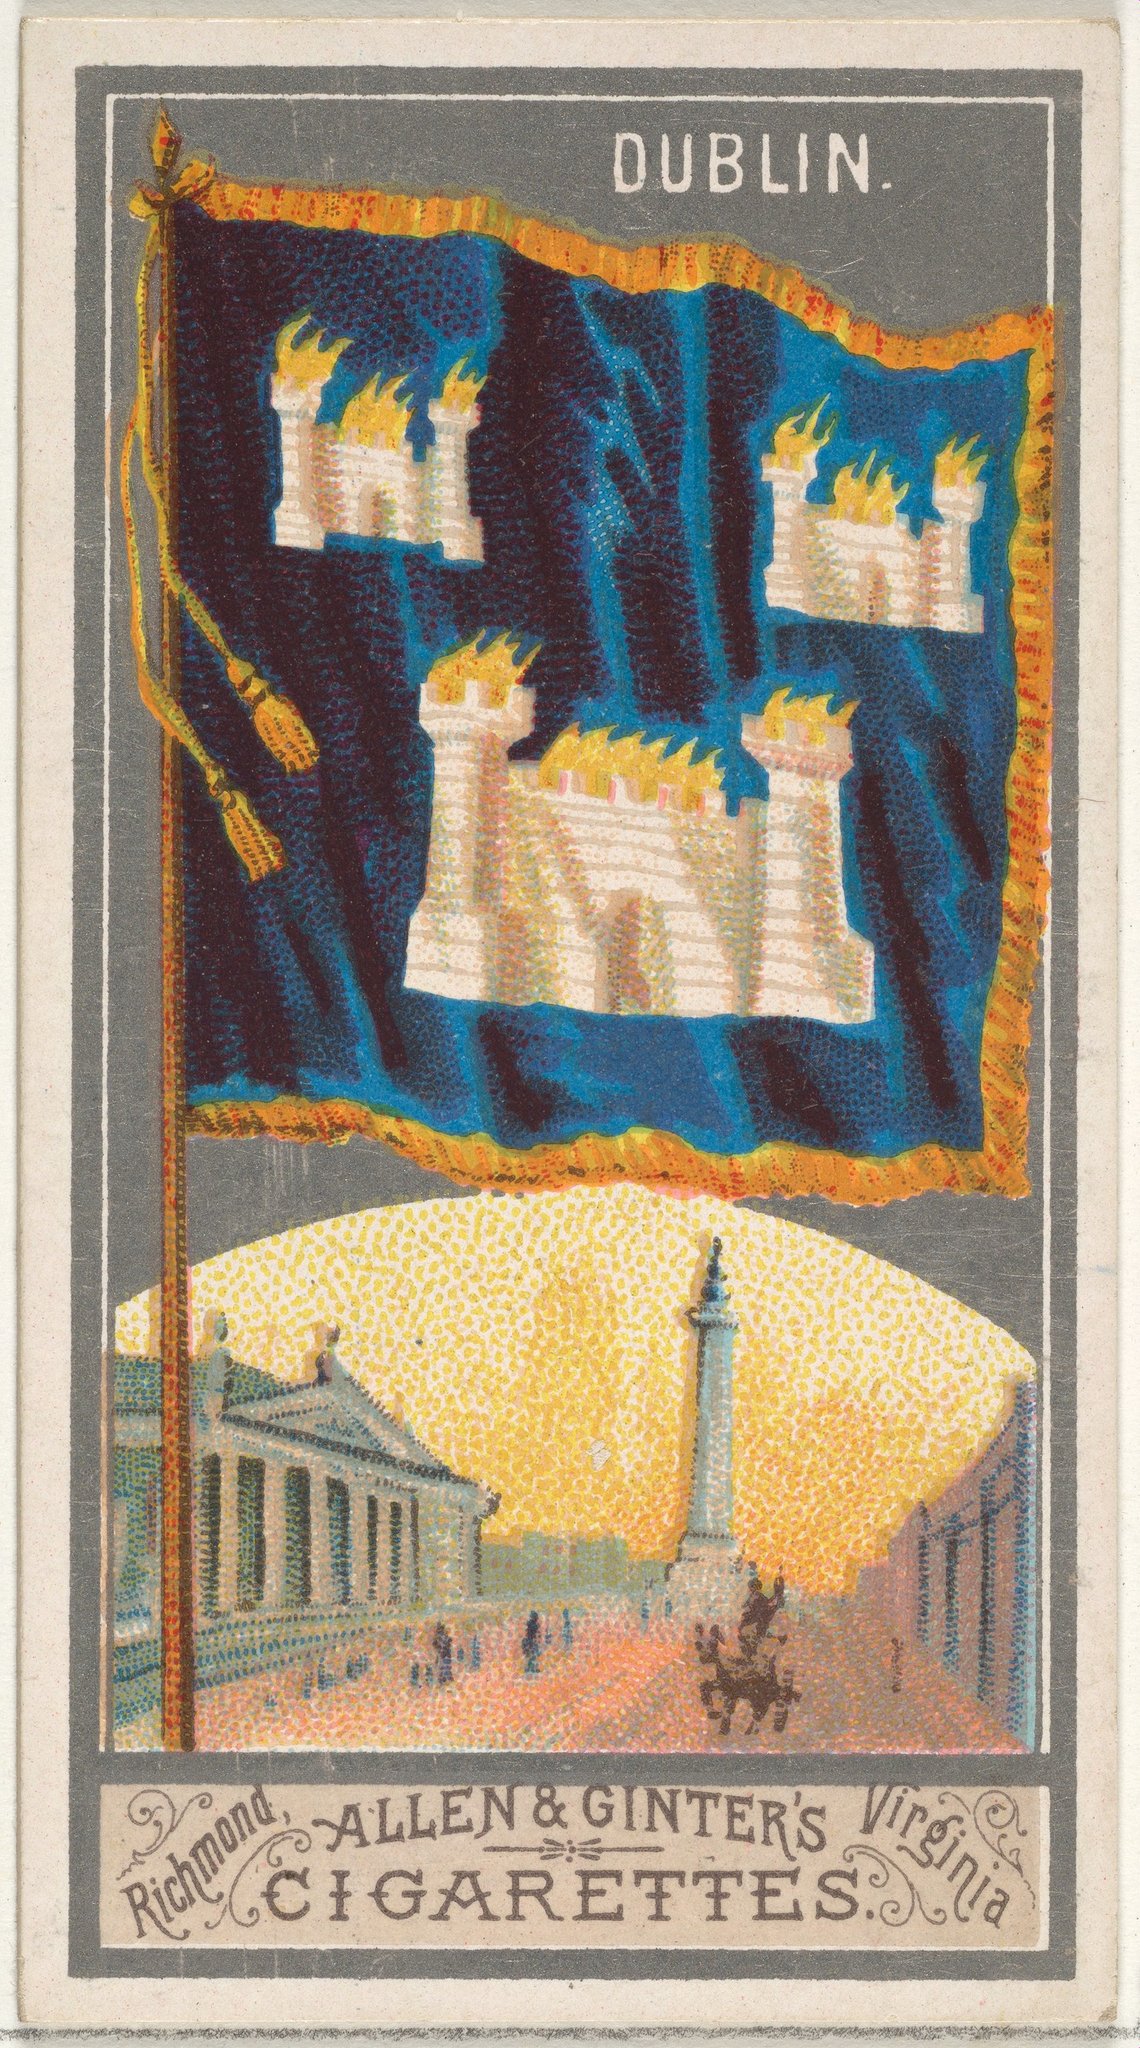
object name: print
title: Dublin, from the City Flags series (N6) for Allen & Ginter Cigarettes Brands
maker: allen & ginter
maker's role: publisher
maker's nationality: american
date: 1887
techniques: color lithograph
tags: flags